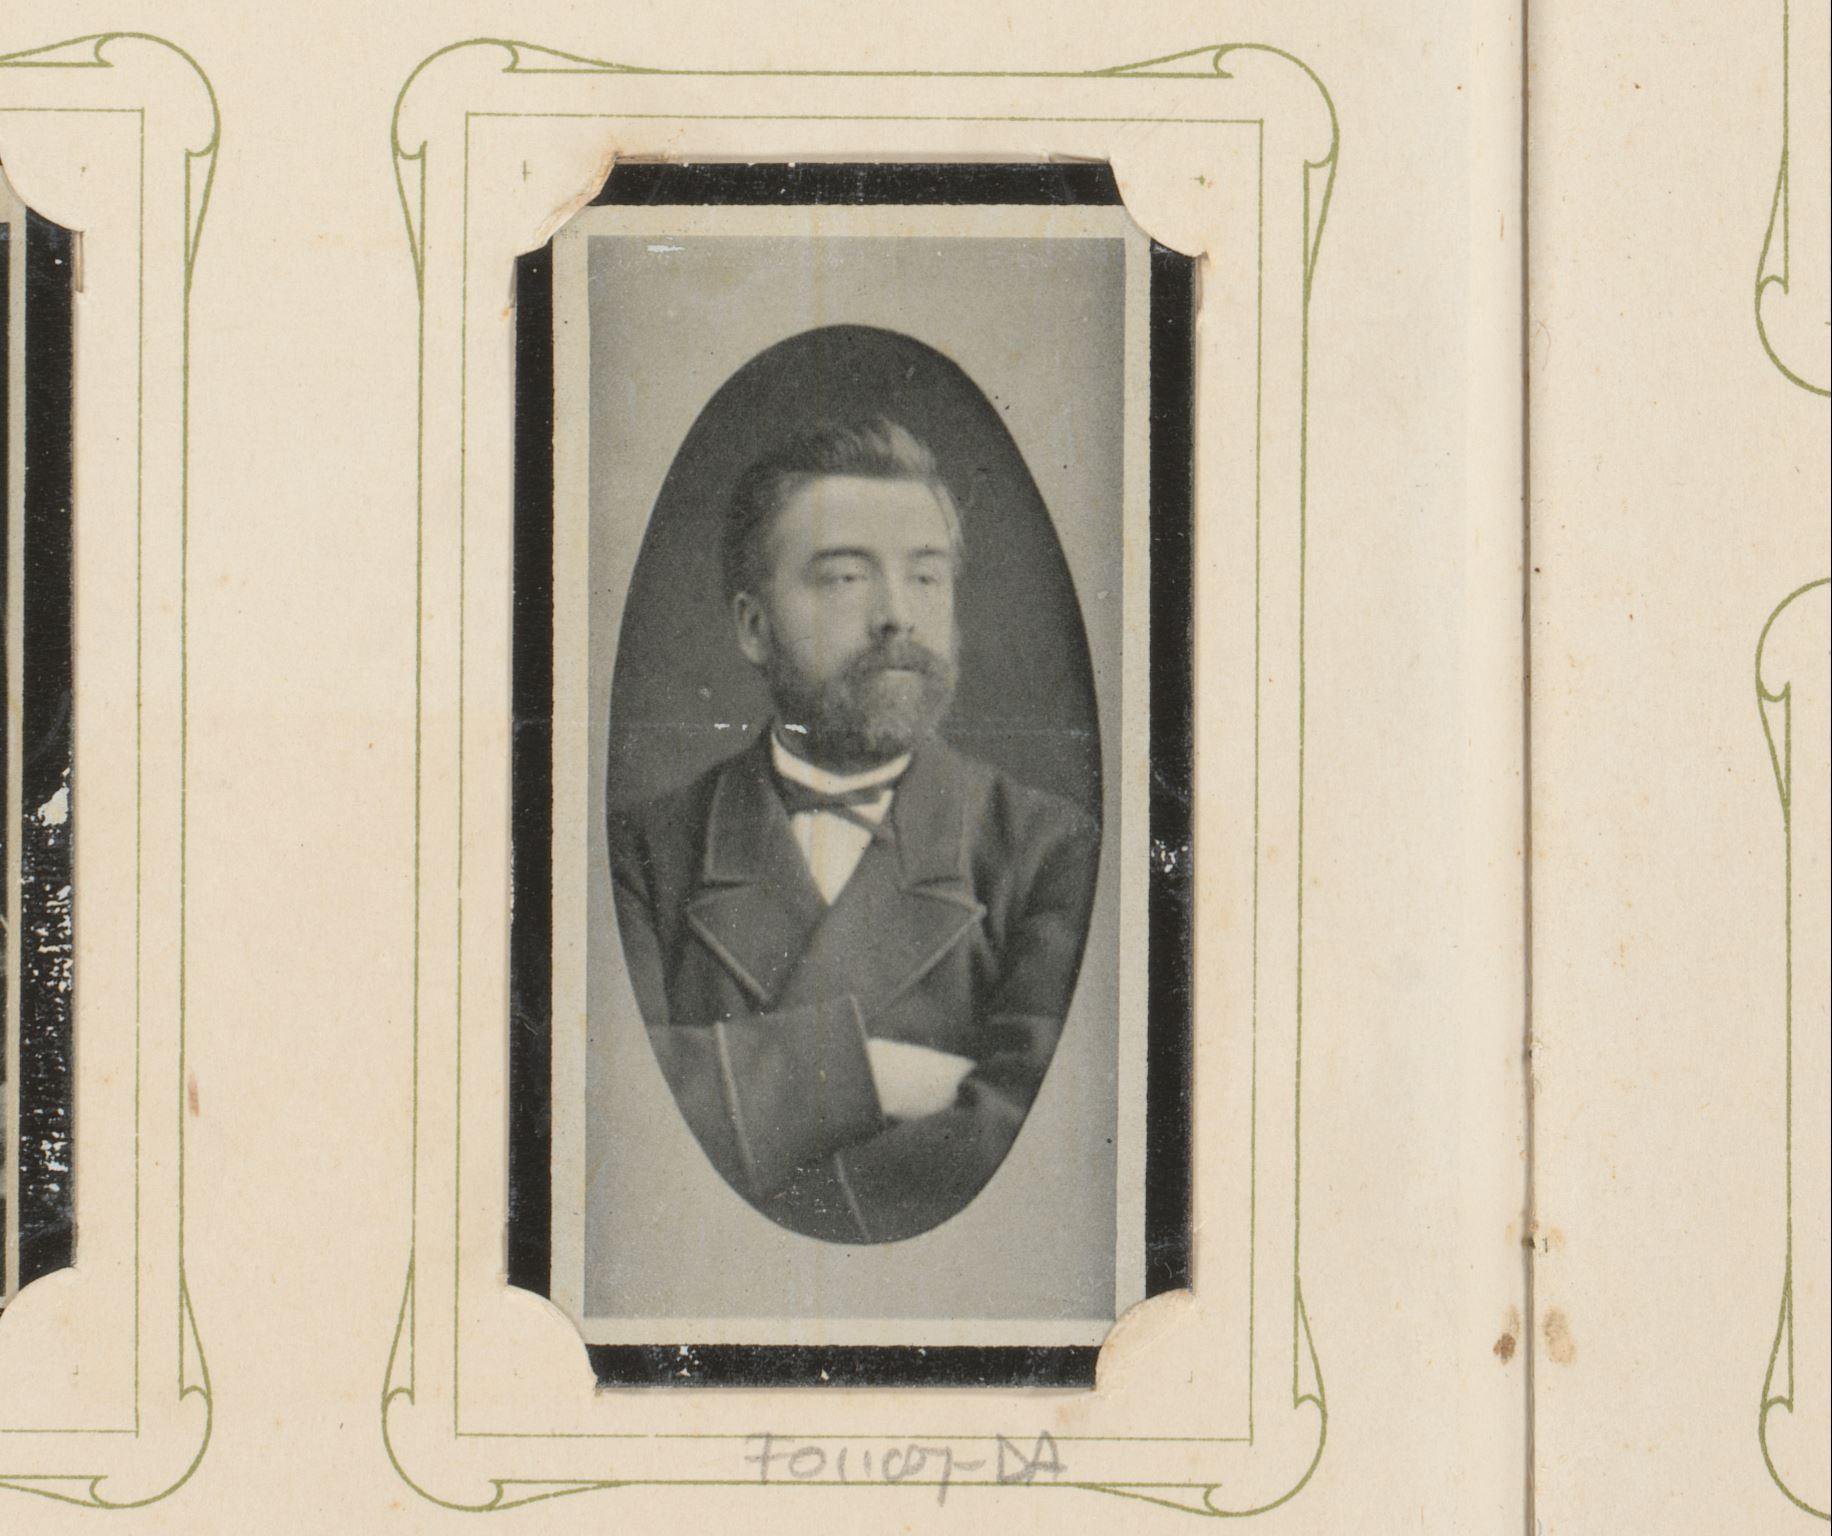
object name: photomechanical print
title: Portret van Anton Mauve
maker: Anonymous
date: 1905-1906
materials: paper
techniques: photograph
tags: arnhem, print maker, draughtsman, anton mauve, historical persons, portrait, self-portrait of painter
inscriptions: inscription: ‘No. 6./ Mauve.’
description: Deze prent maakt deel uit van een album.